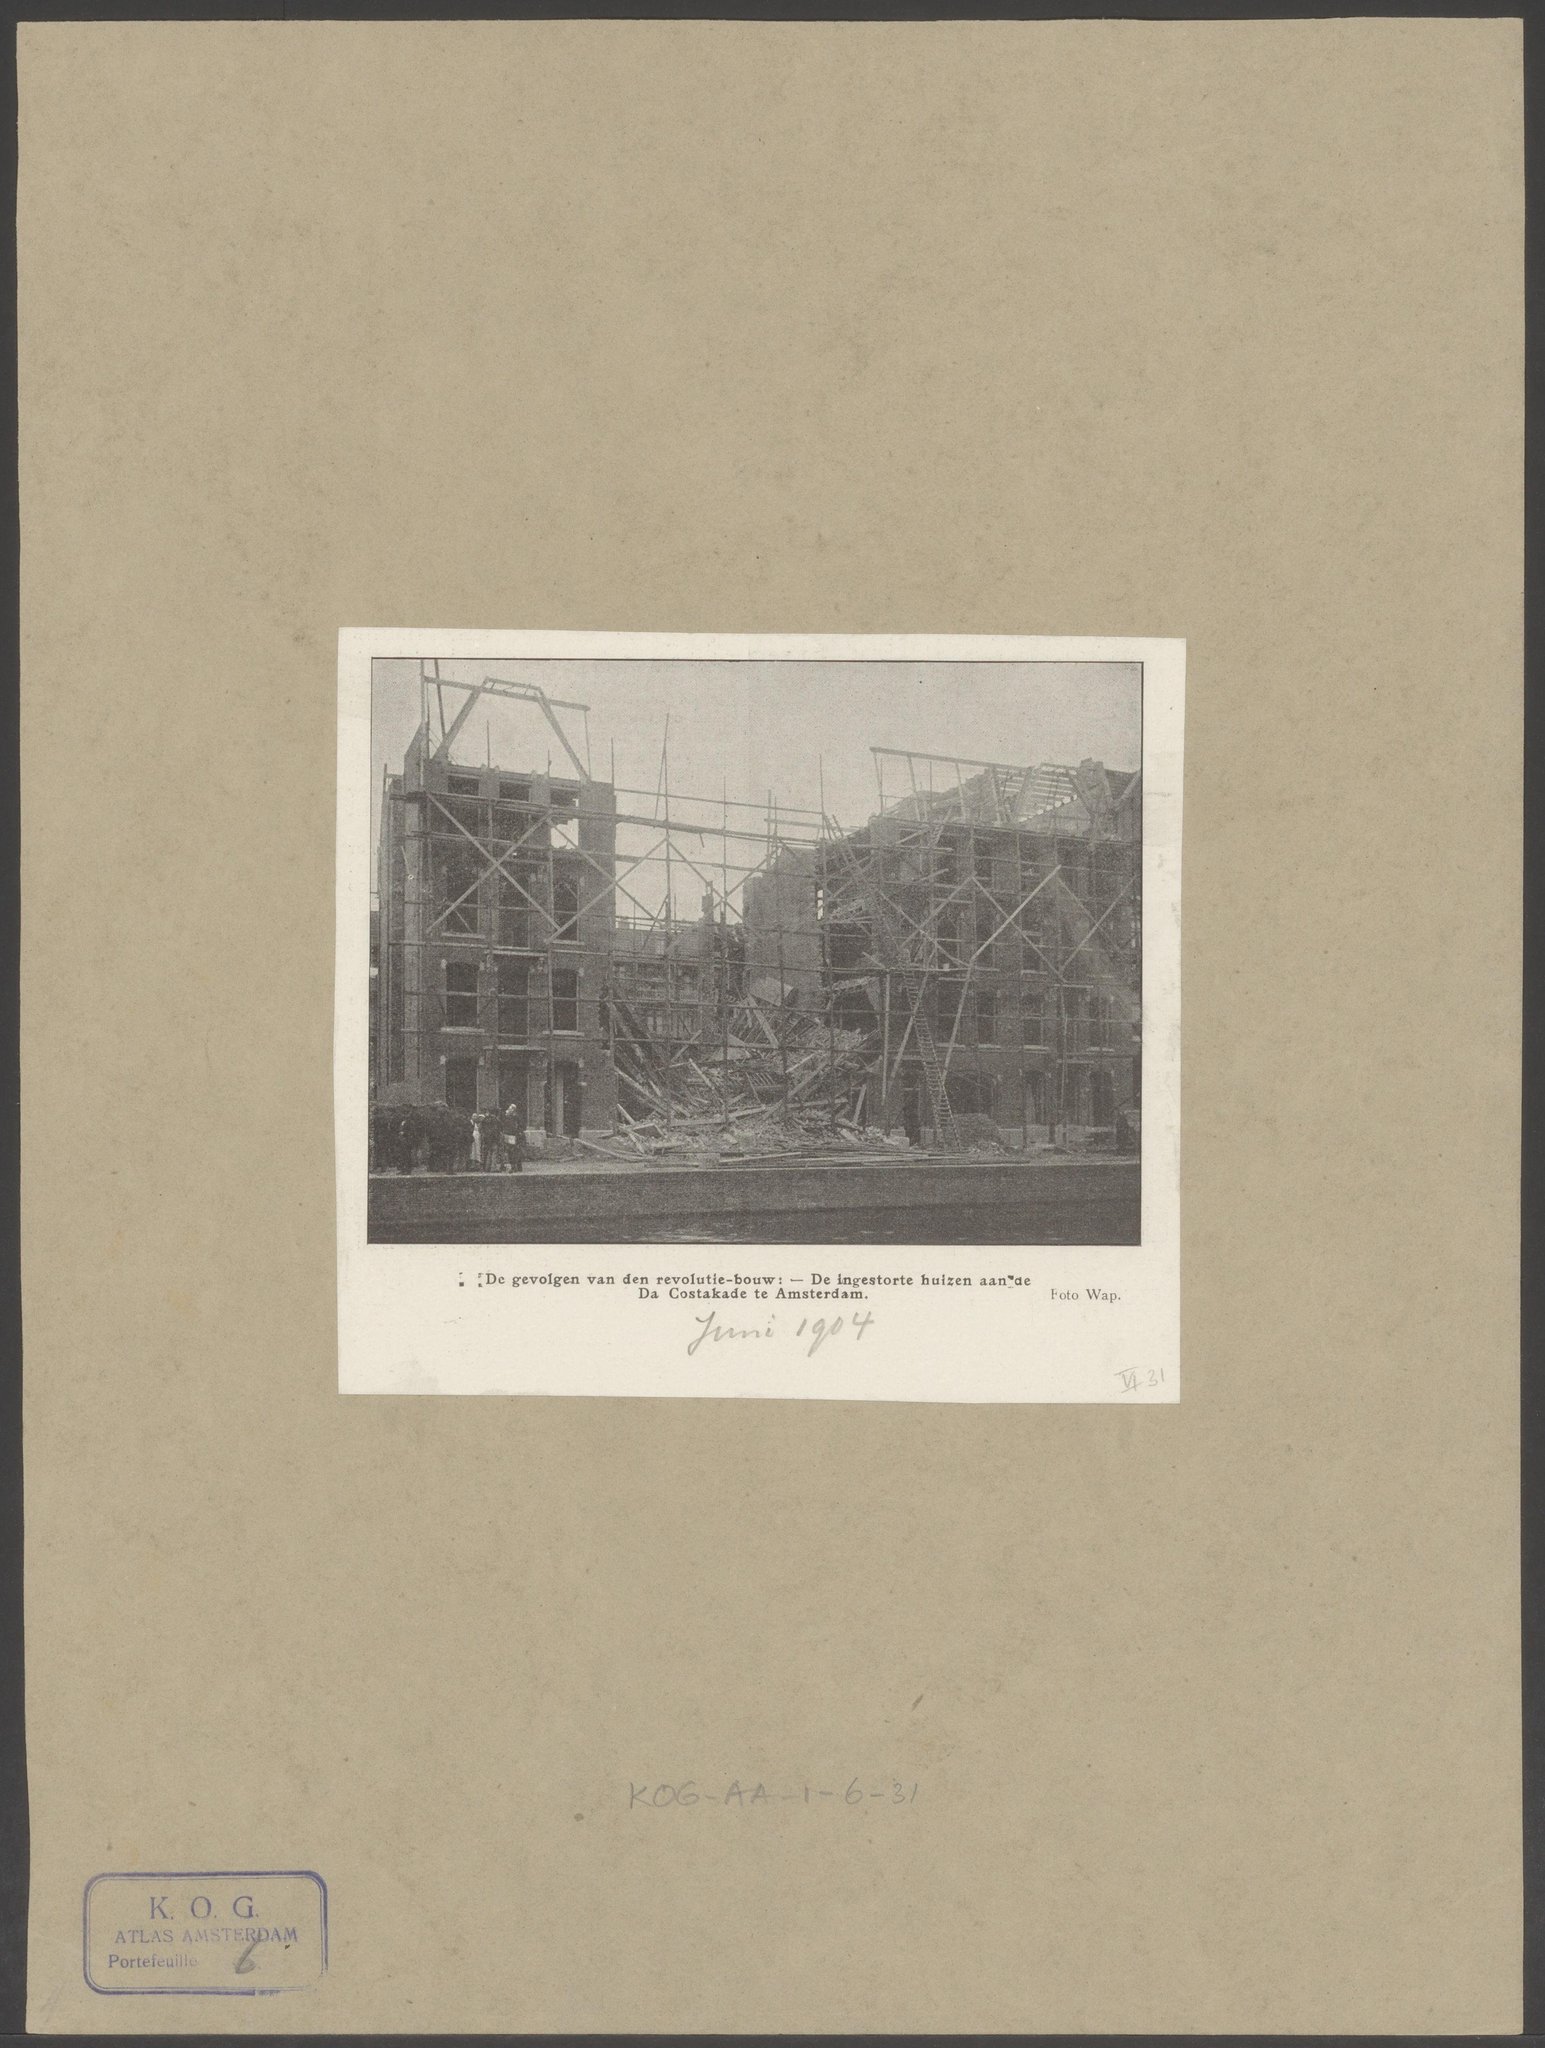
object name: photomechanical print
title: Gezicht op twee ingestorte huizen aan de Da Costakade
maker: Anonymous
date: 1904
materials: paper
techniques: letterpress printing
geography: amsterdam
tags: city-view in general; 'veduta', collapsing building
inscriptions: inscription: ‘Juni 1904’, collector's mark: ‘6’ Lugt 1641b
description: Onderwerpsrubriek binnen de Atlas Amsterdam: Buijskade, Catskade (Jacob), Clercqstraat (de), Commelinstraat, Costakade (da), Cuypstraat (Albert), Czaar Peterstraat.